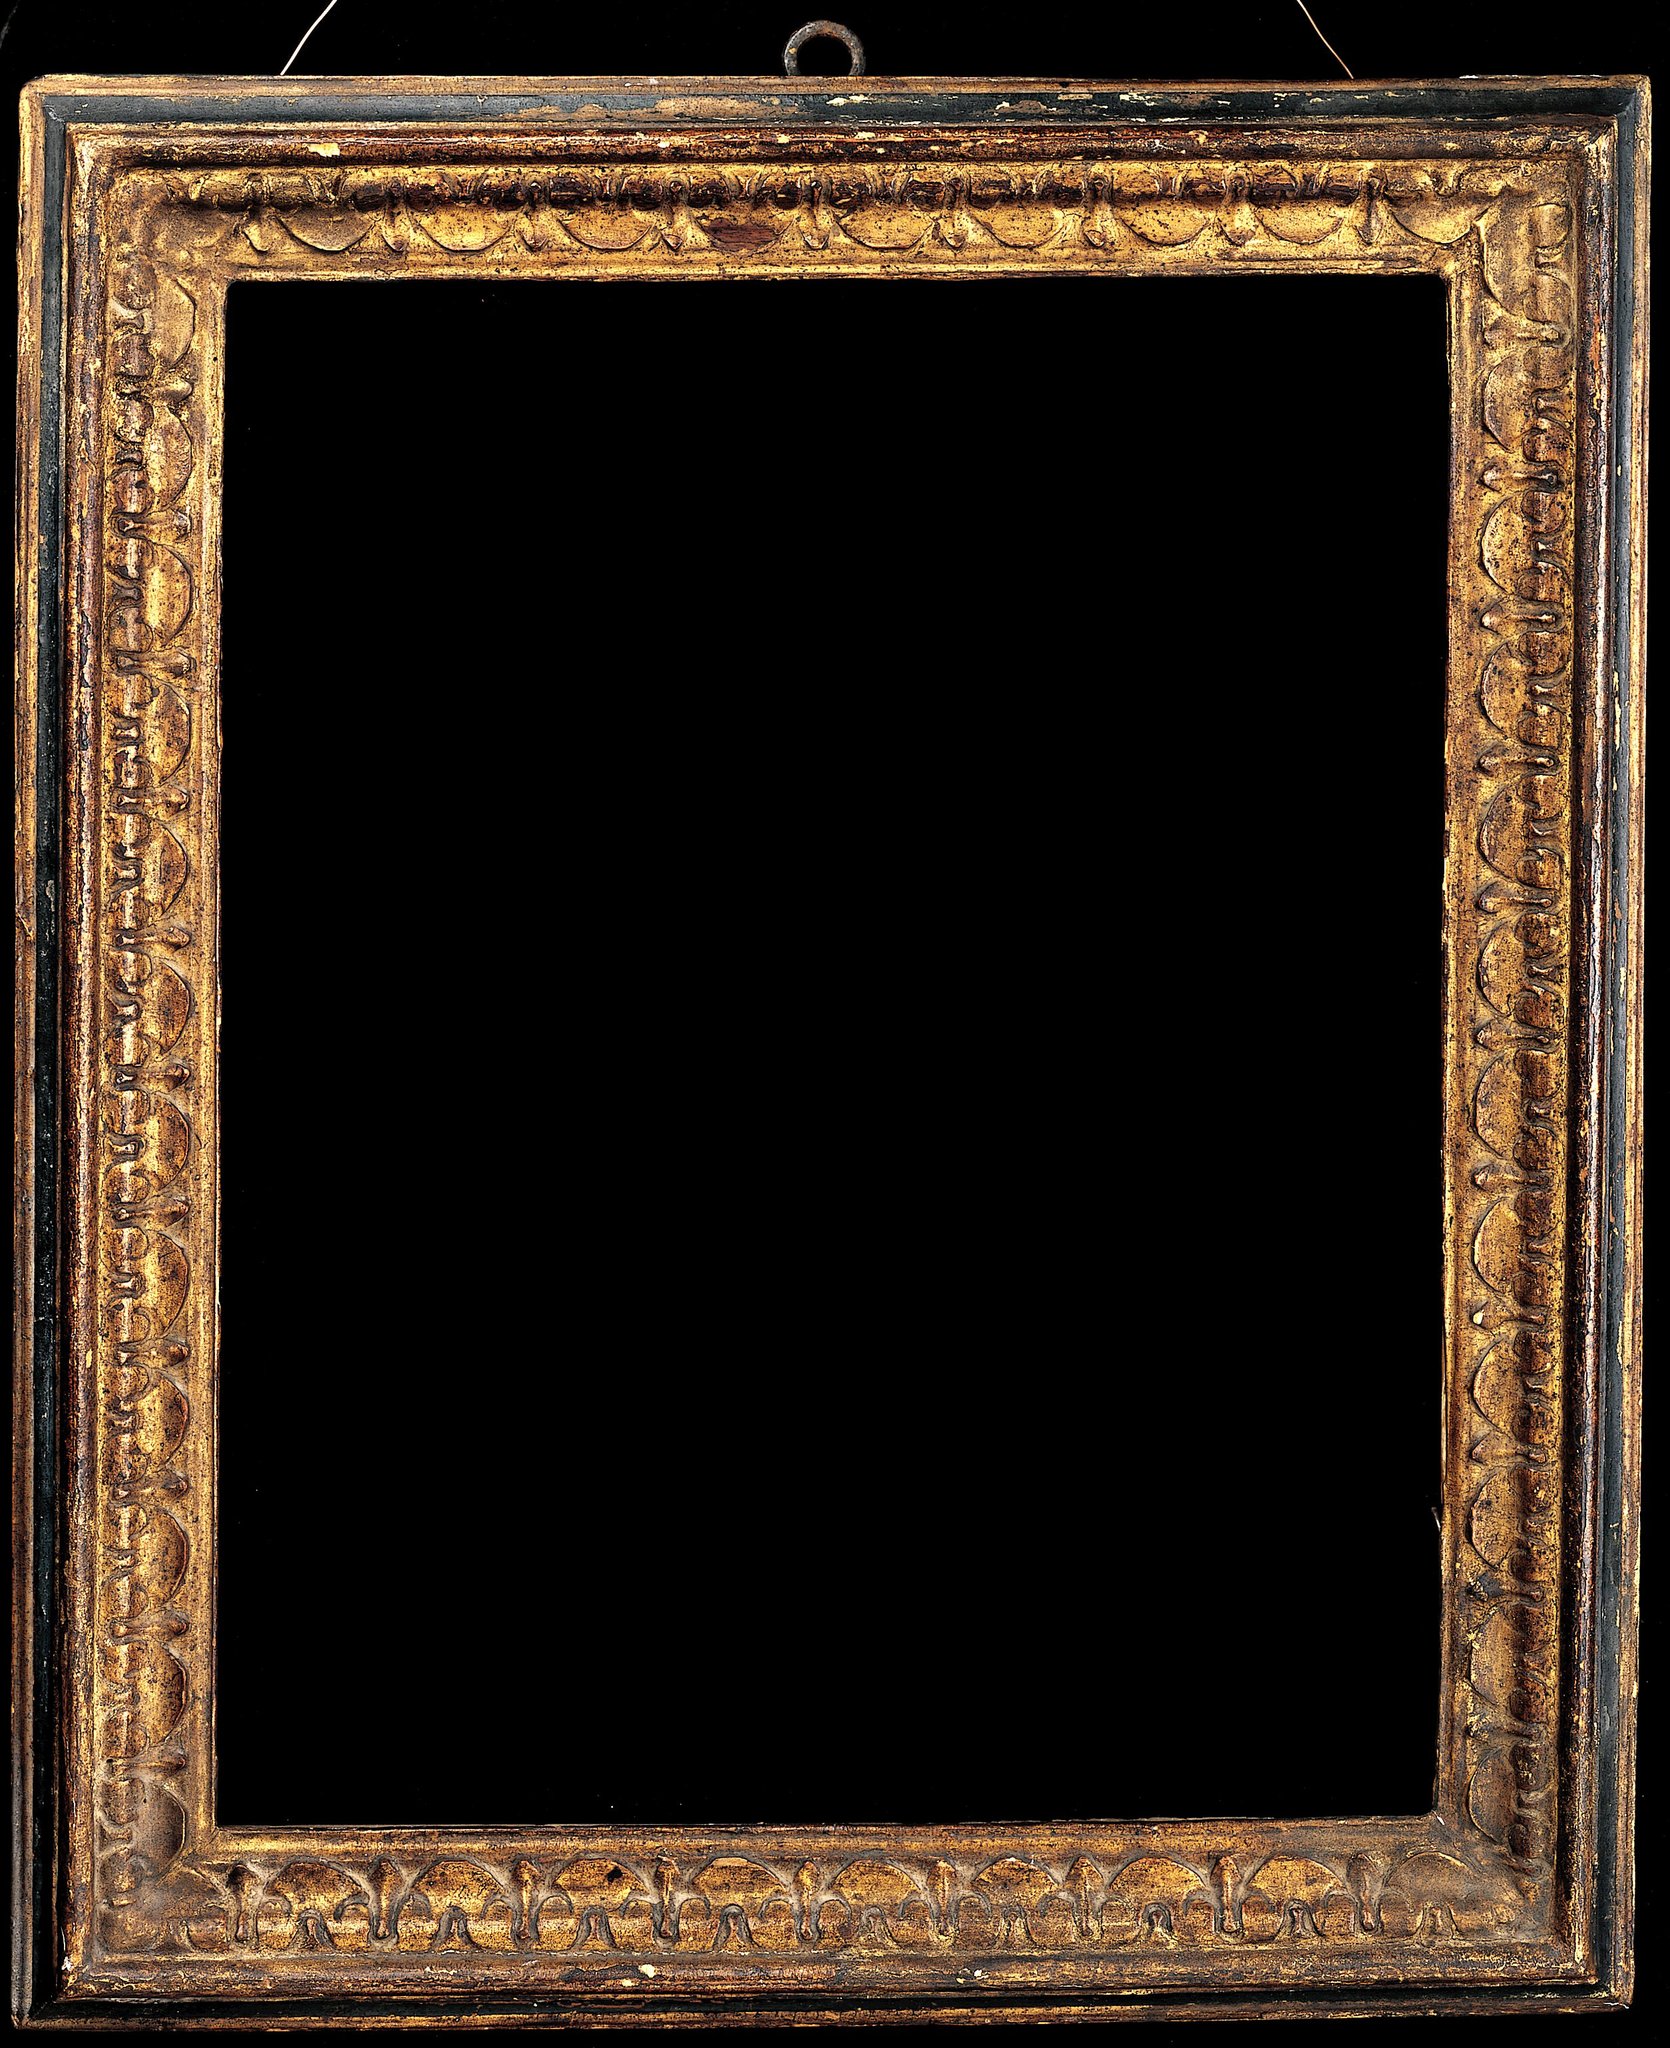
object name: frame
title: Ogee frame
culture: italian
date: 1570-1575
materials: wood